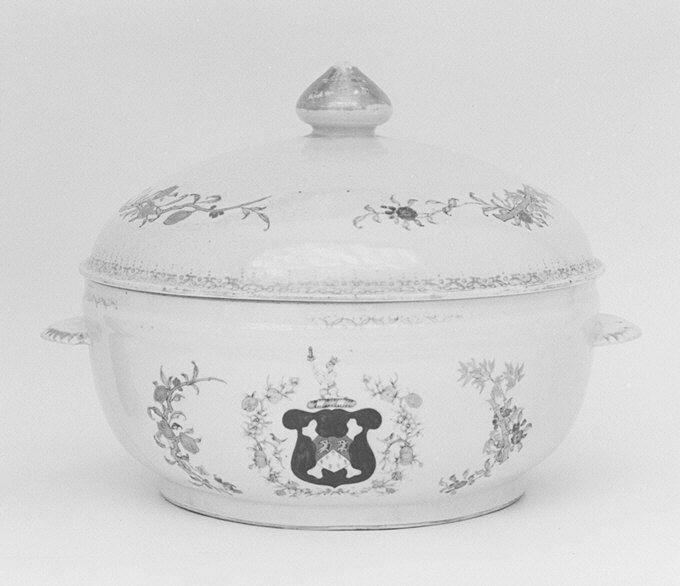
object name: tureen with cover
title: Tureen with cover (part of a service)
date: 1740-1750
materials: hard paste porcelain